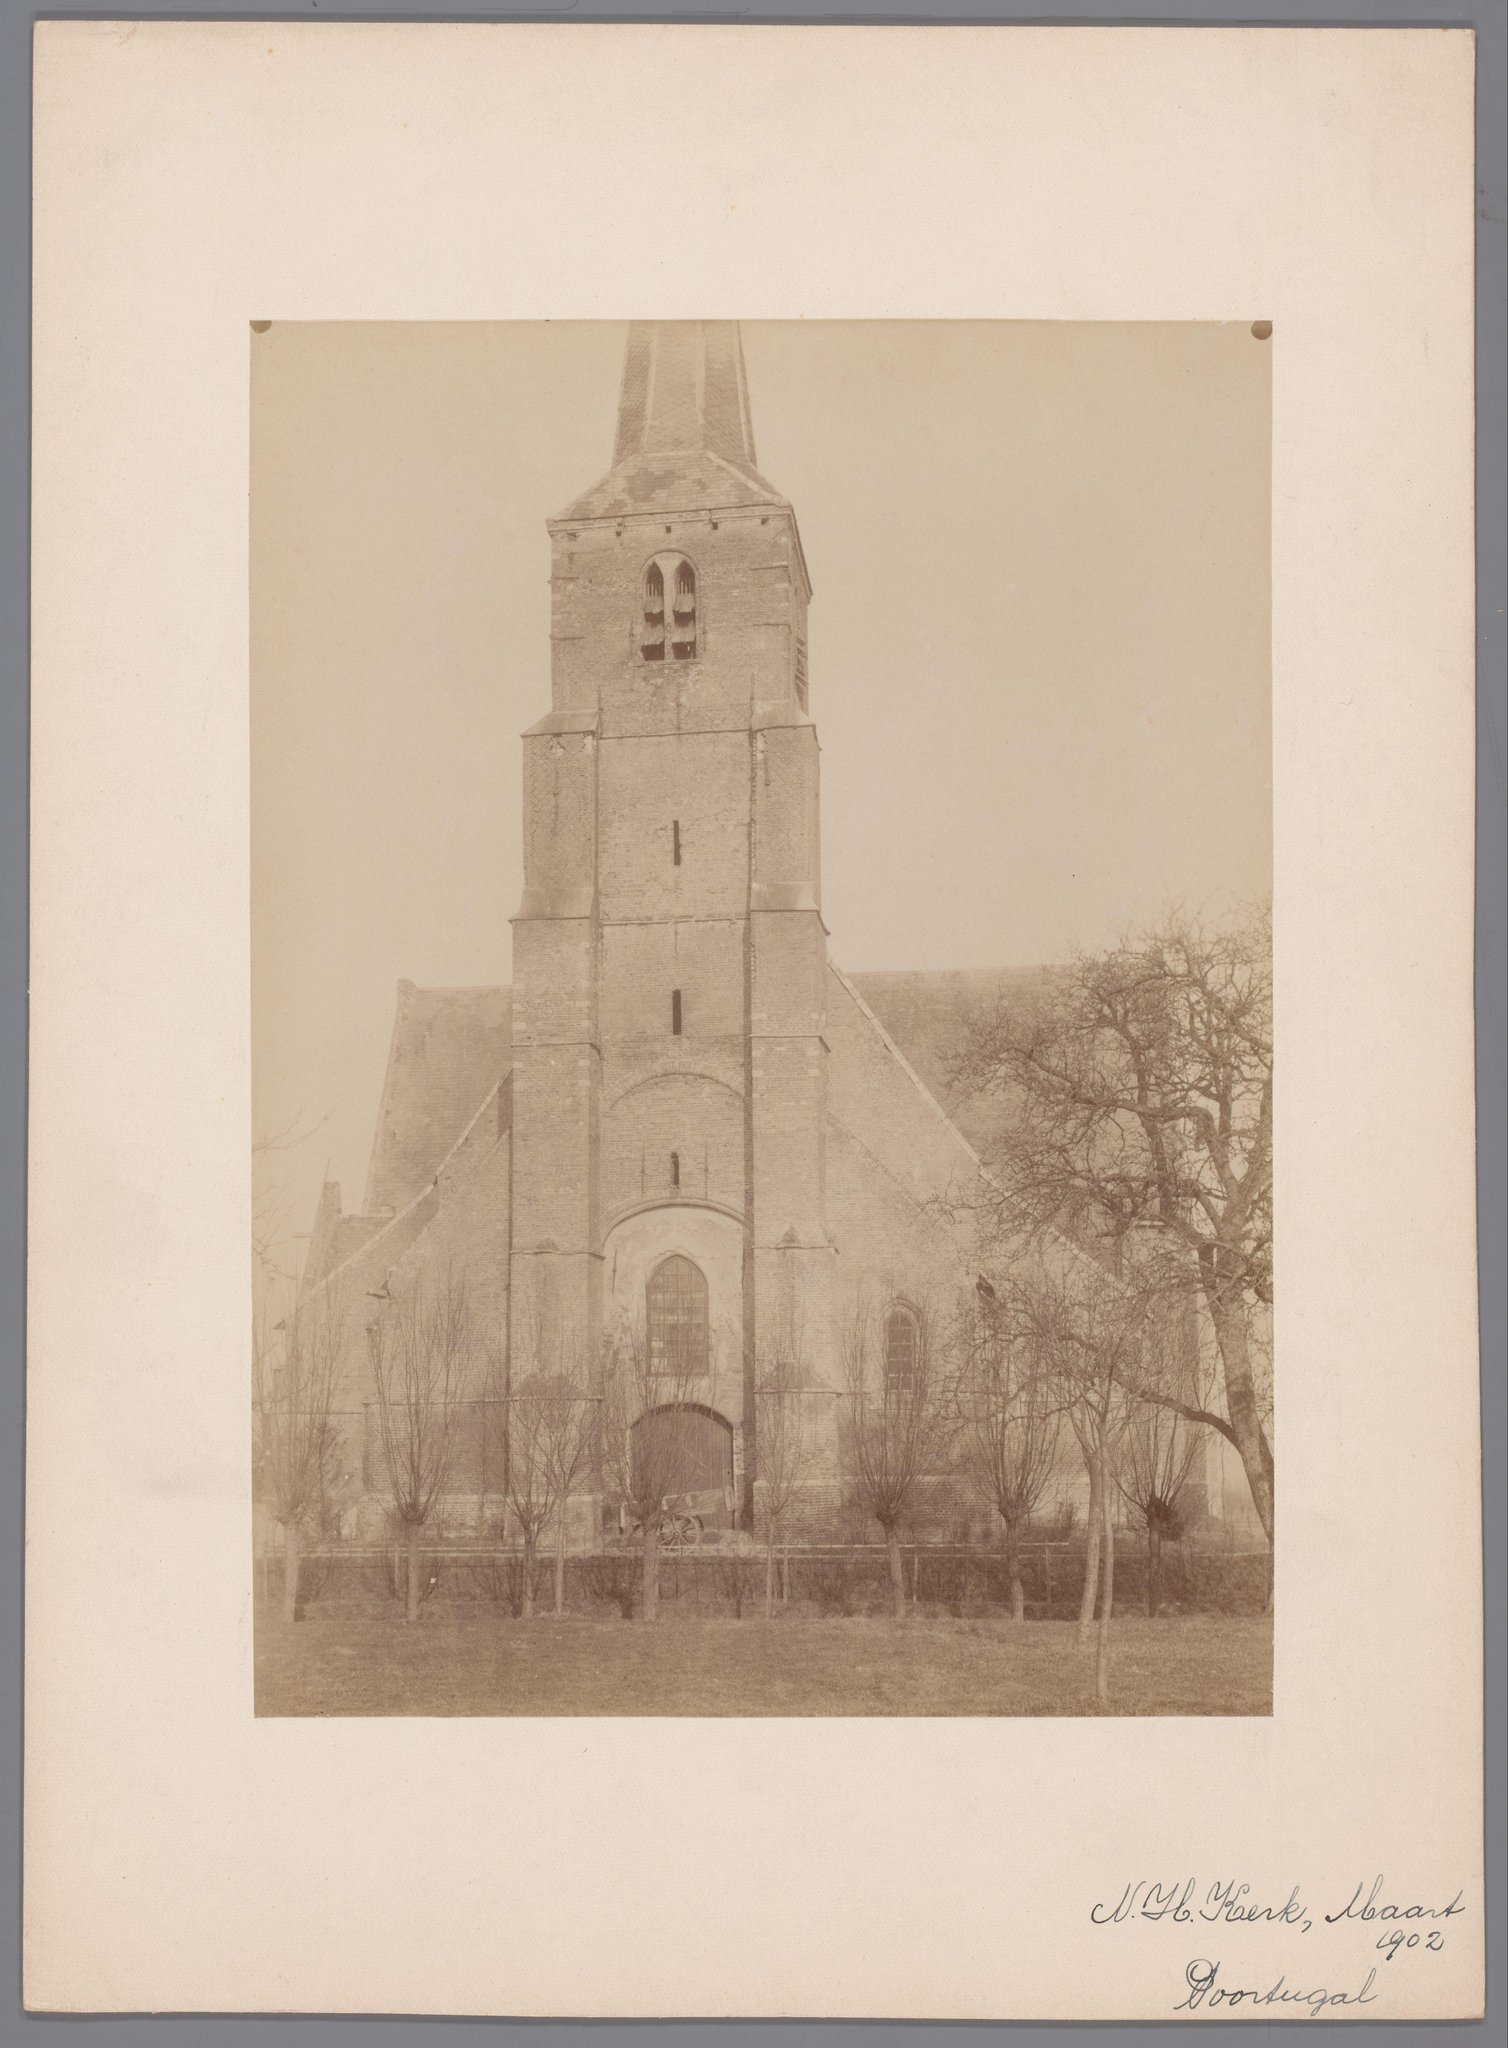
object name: photograph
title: Gezicht op de Dorpskerk te Poortugaal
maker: anoniem (monumentenzorg)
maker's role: fotograaf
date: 1902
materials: cardboard, photographic support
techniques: albumen print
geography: poortugaal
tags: church (exterior)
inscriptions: annotation: ‘Poortugaal N.H. Kerk (Z.H.)/ opgemeten Maart 1902’, annotation: ‘N.H. Kerk, Maart 1902/ Poortugaal’